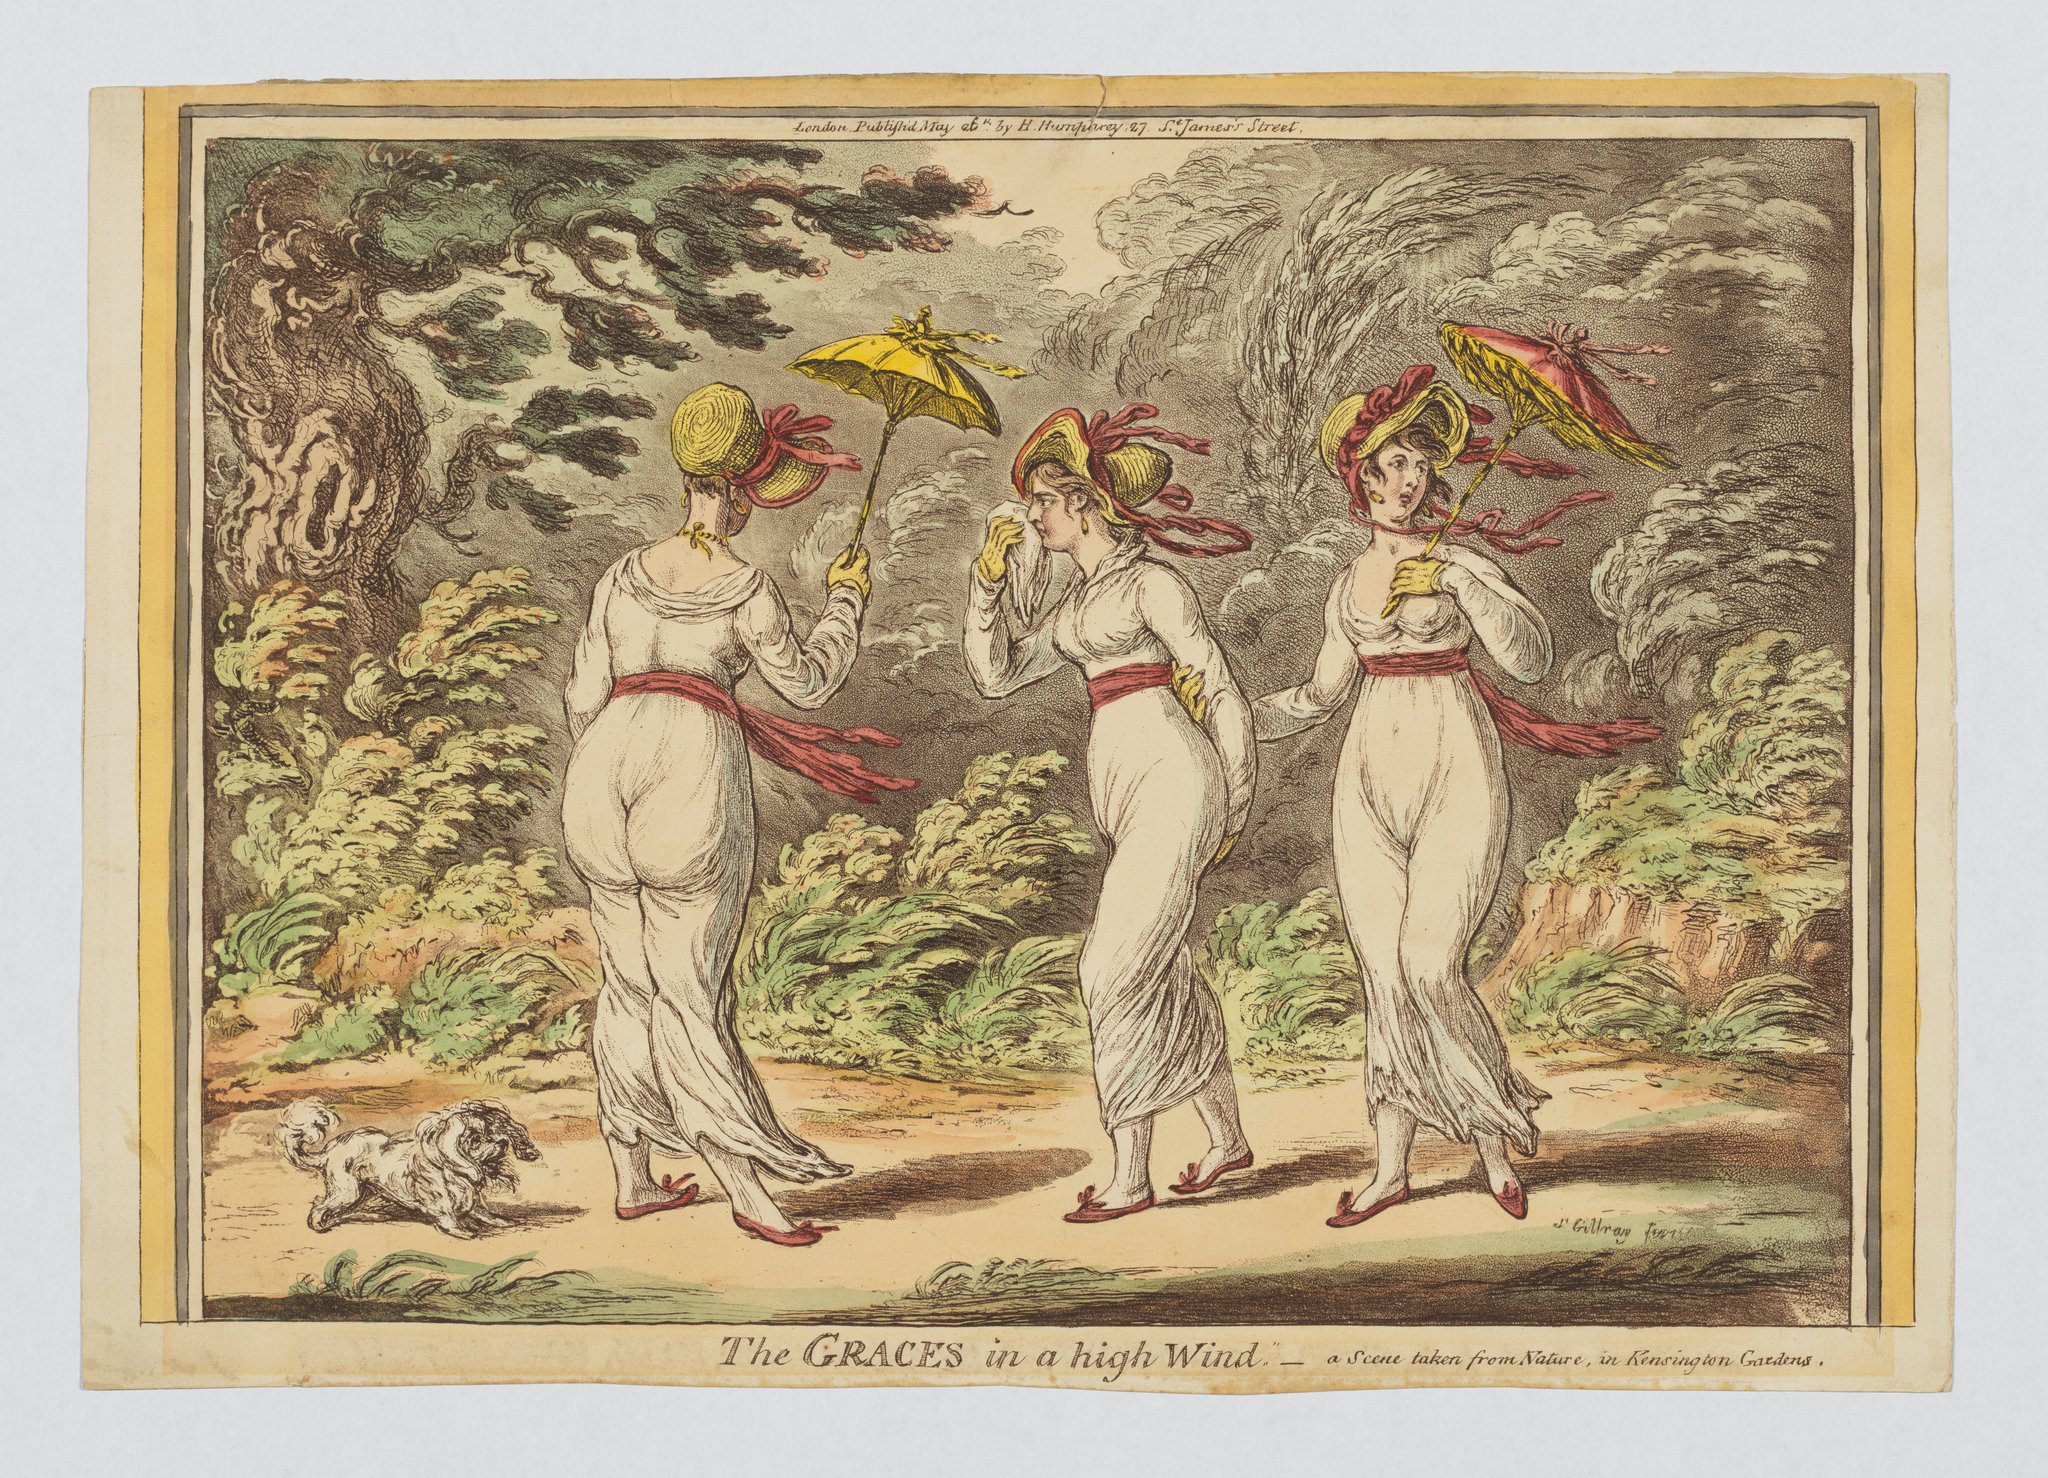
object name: print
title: The Graces in a High Wind – a Scene taken from Nature in Kensington Gardens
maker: james gillray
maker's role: artist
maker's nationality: british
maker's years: 1756-1815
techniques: aquatint, engraving, etching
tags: satire,women,dogs,wind